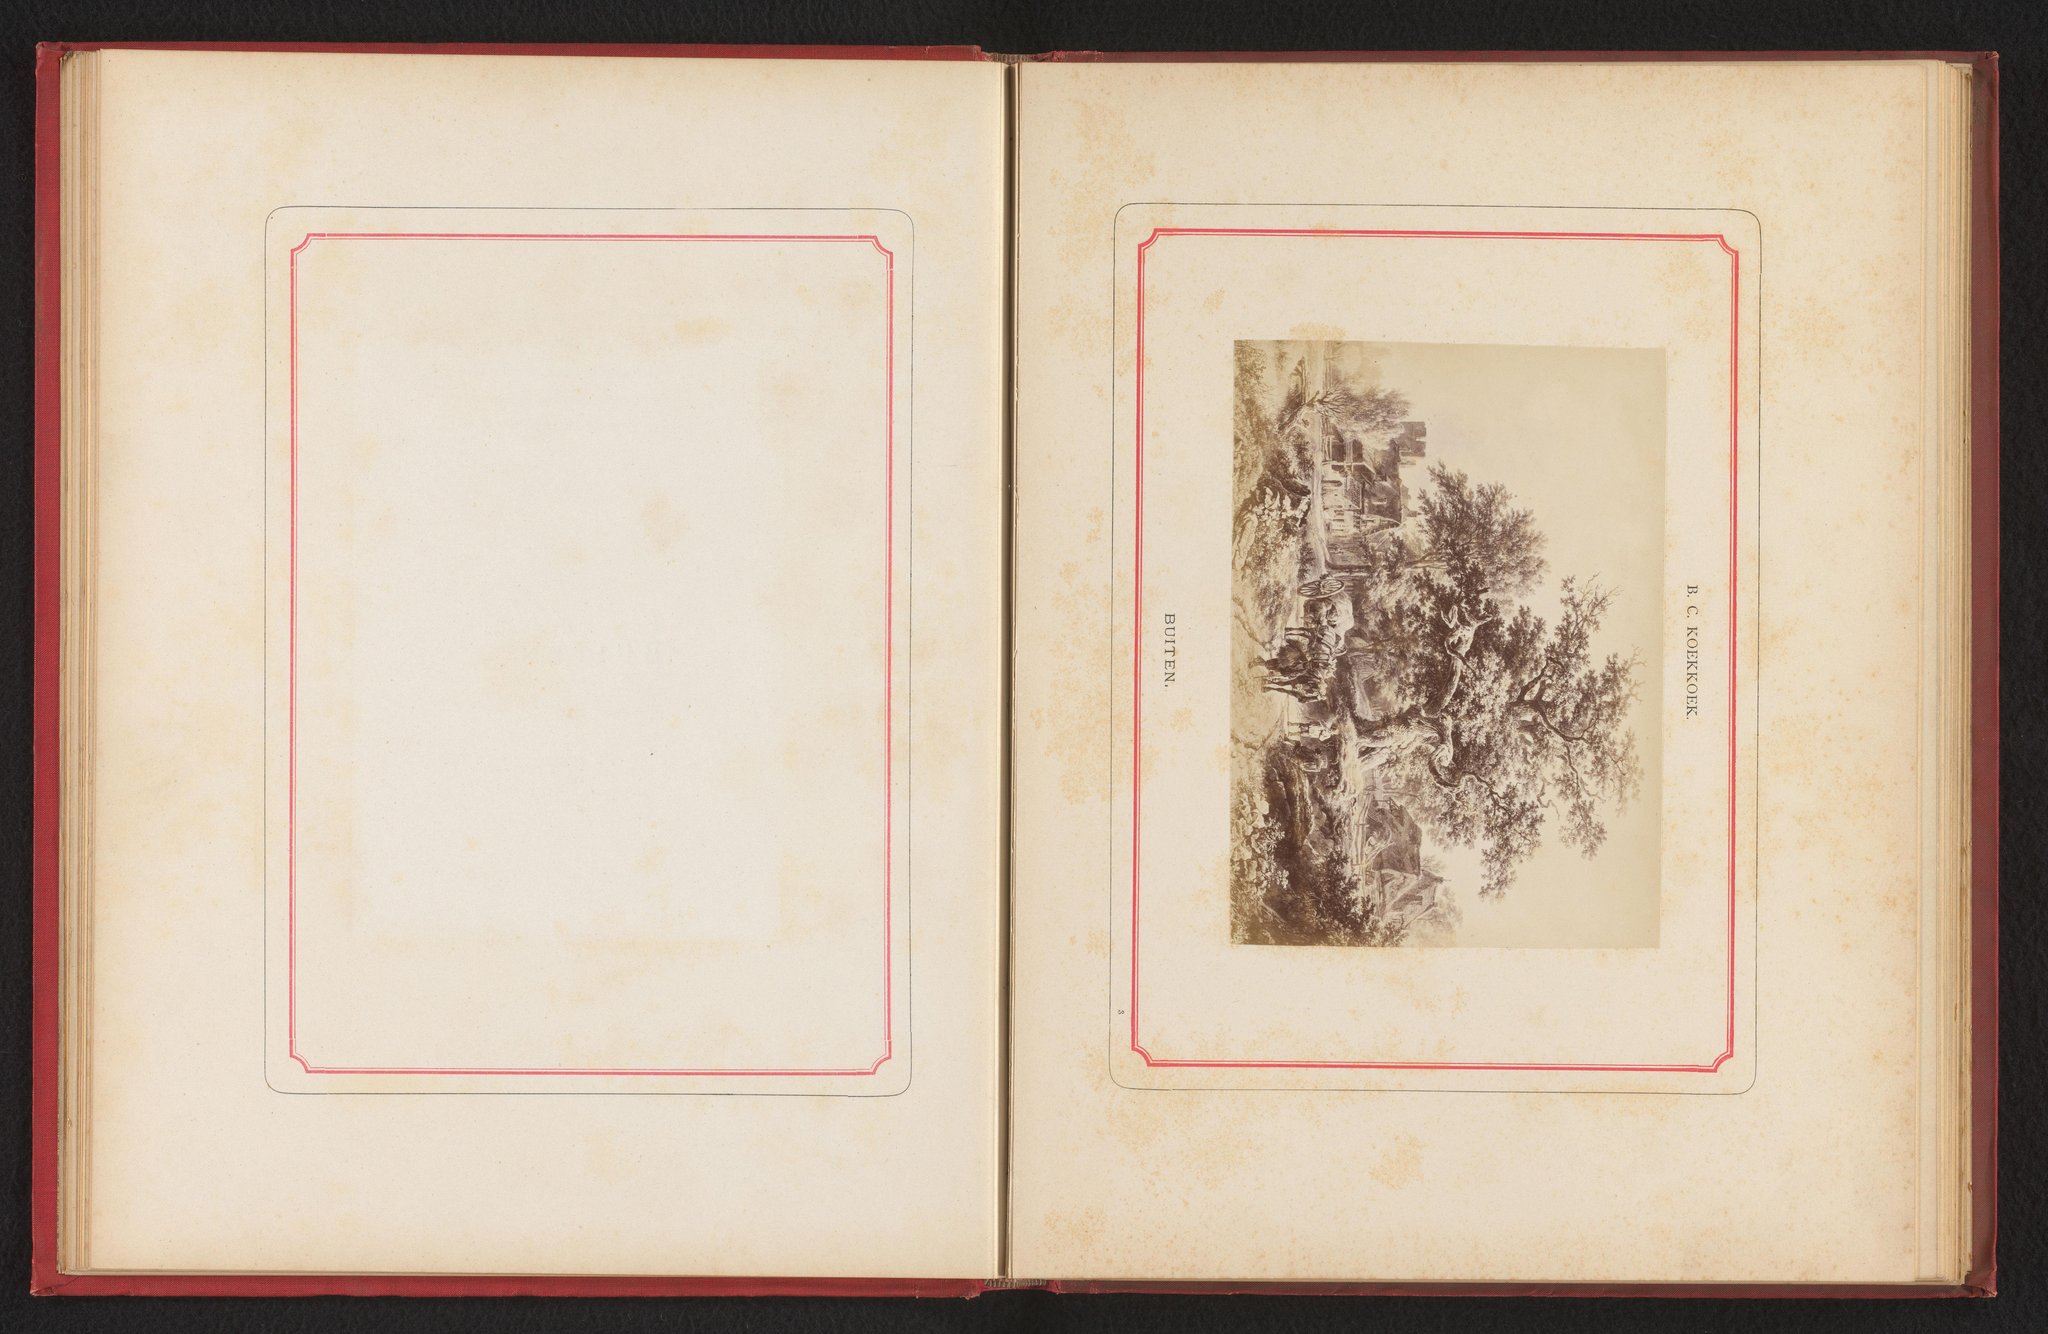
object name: reproduction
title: Fotoreproductie van het schilderij 'Buiten' door Barend Cornelis Koekkoek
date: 1865-1878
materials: paper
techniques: albumen print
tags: farmers